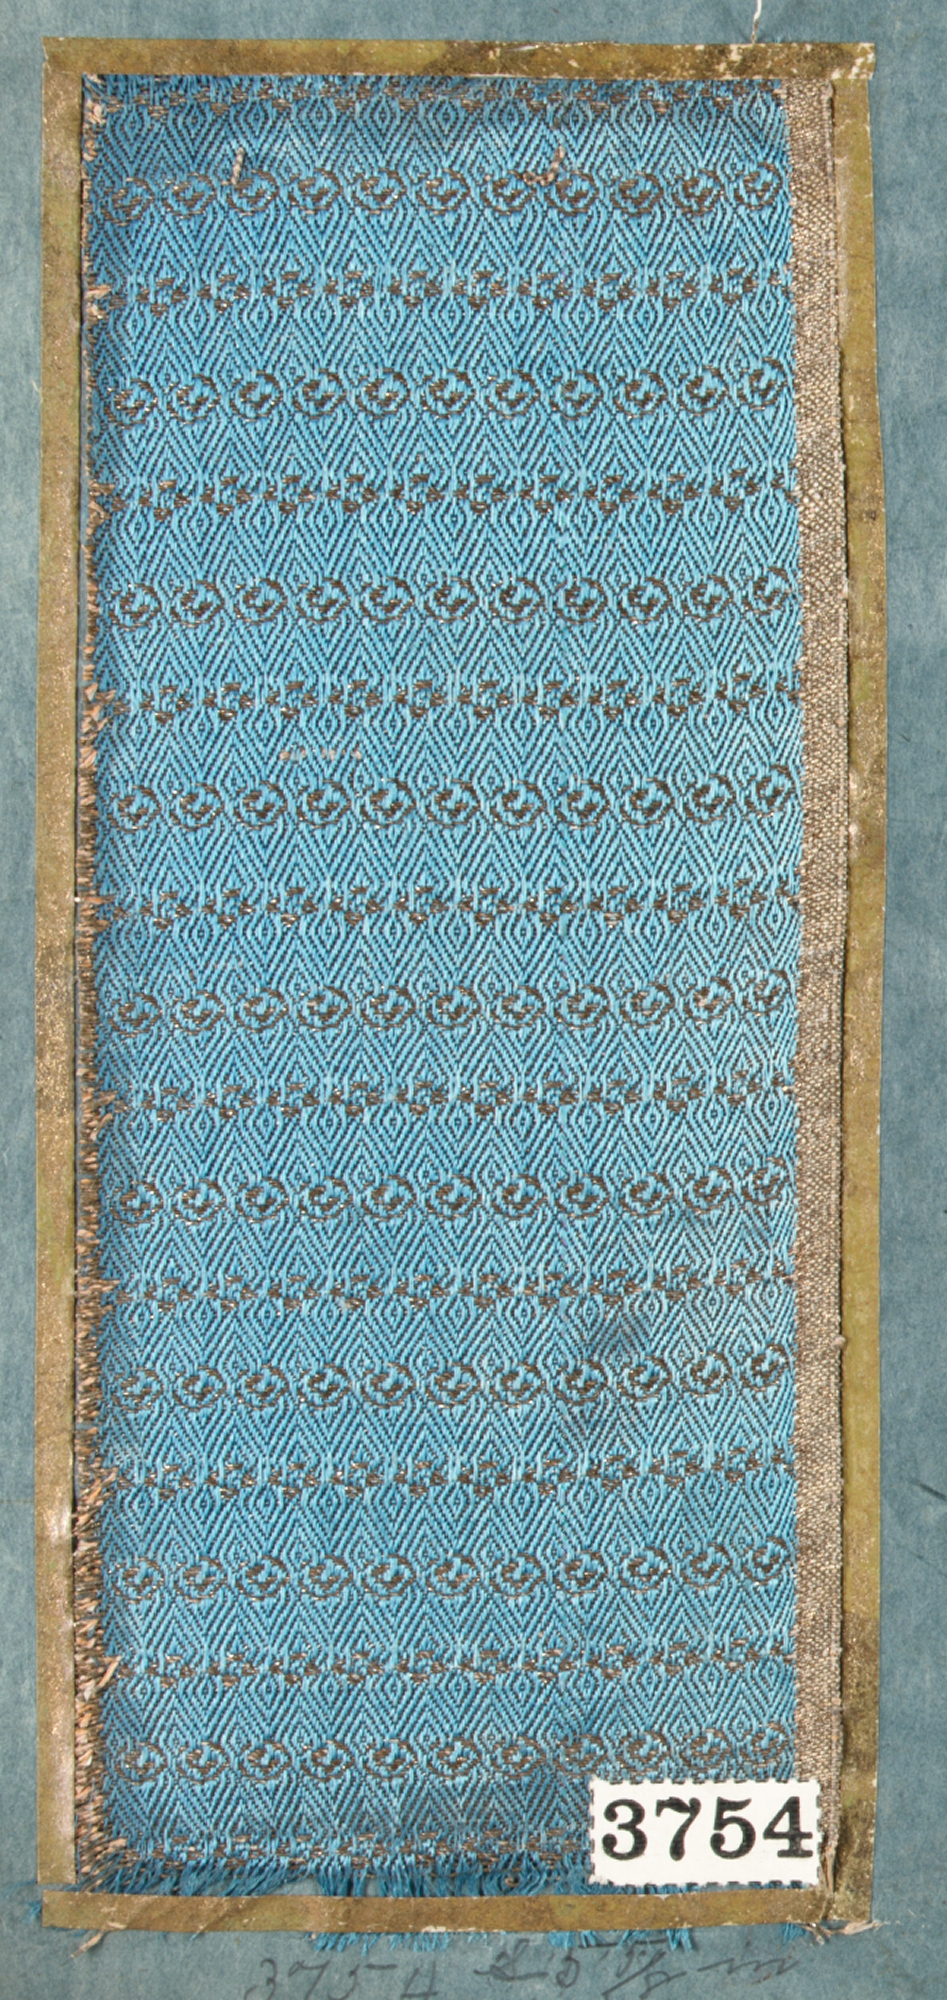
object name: sample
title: Textile Sample from Sample Book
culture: japanese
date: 1801-1900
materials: silk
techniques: tapestry